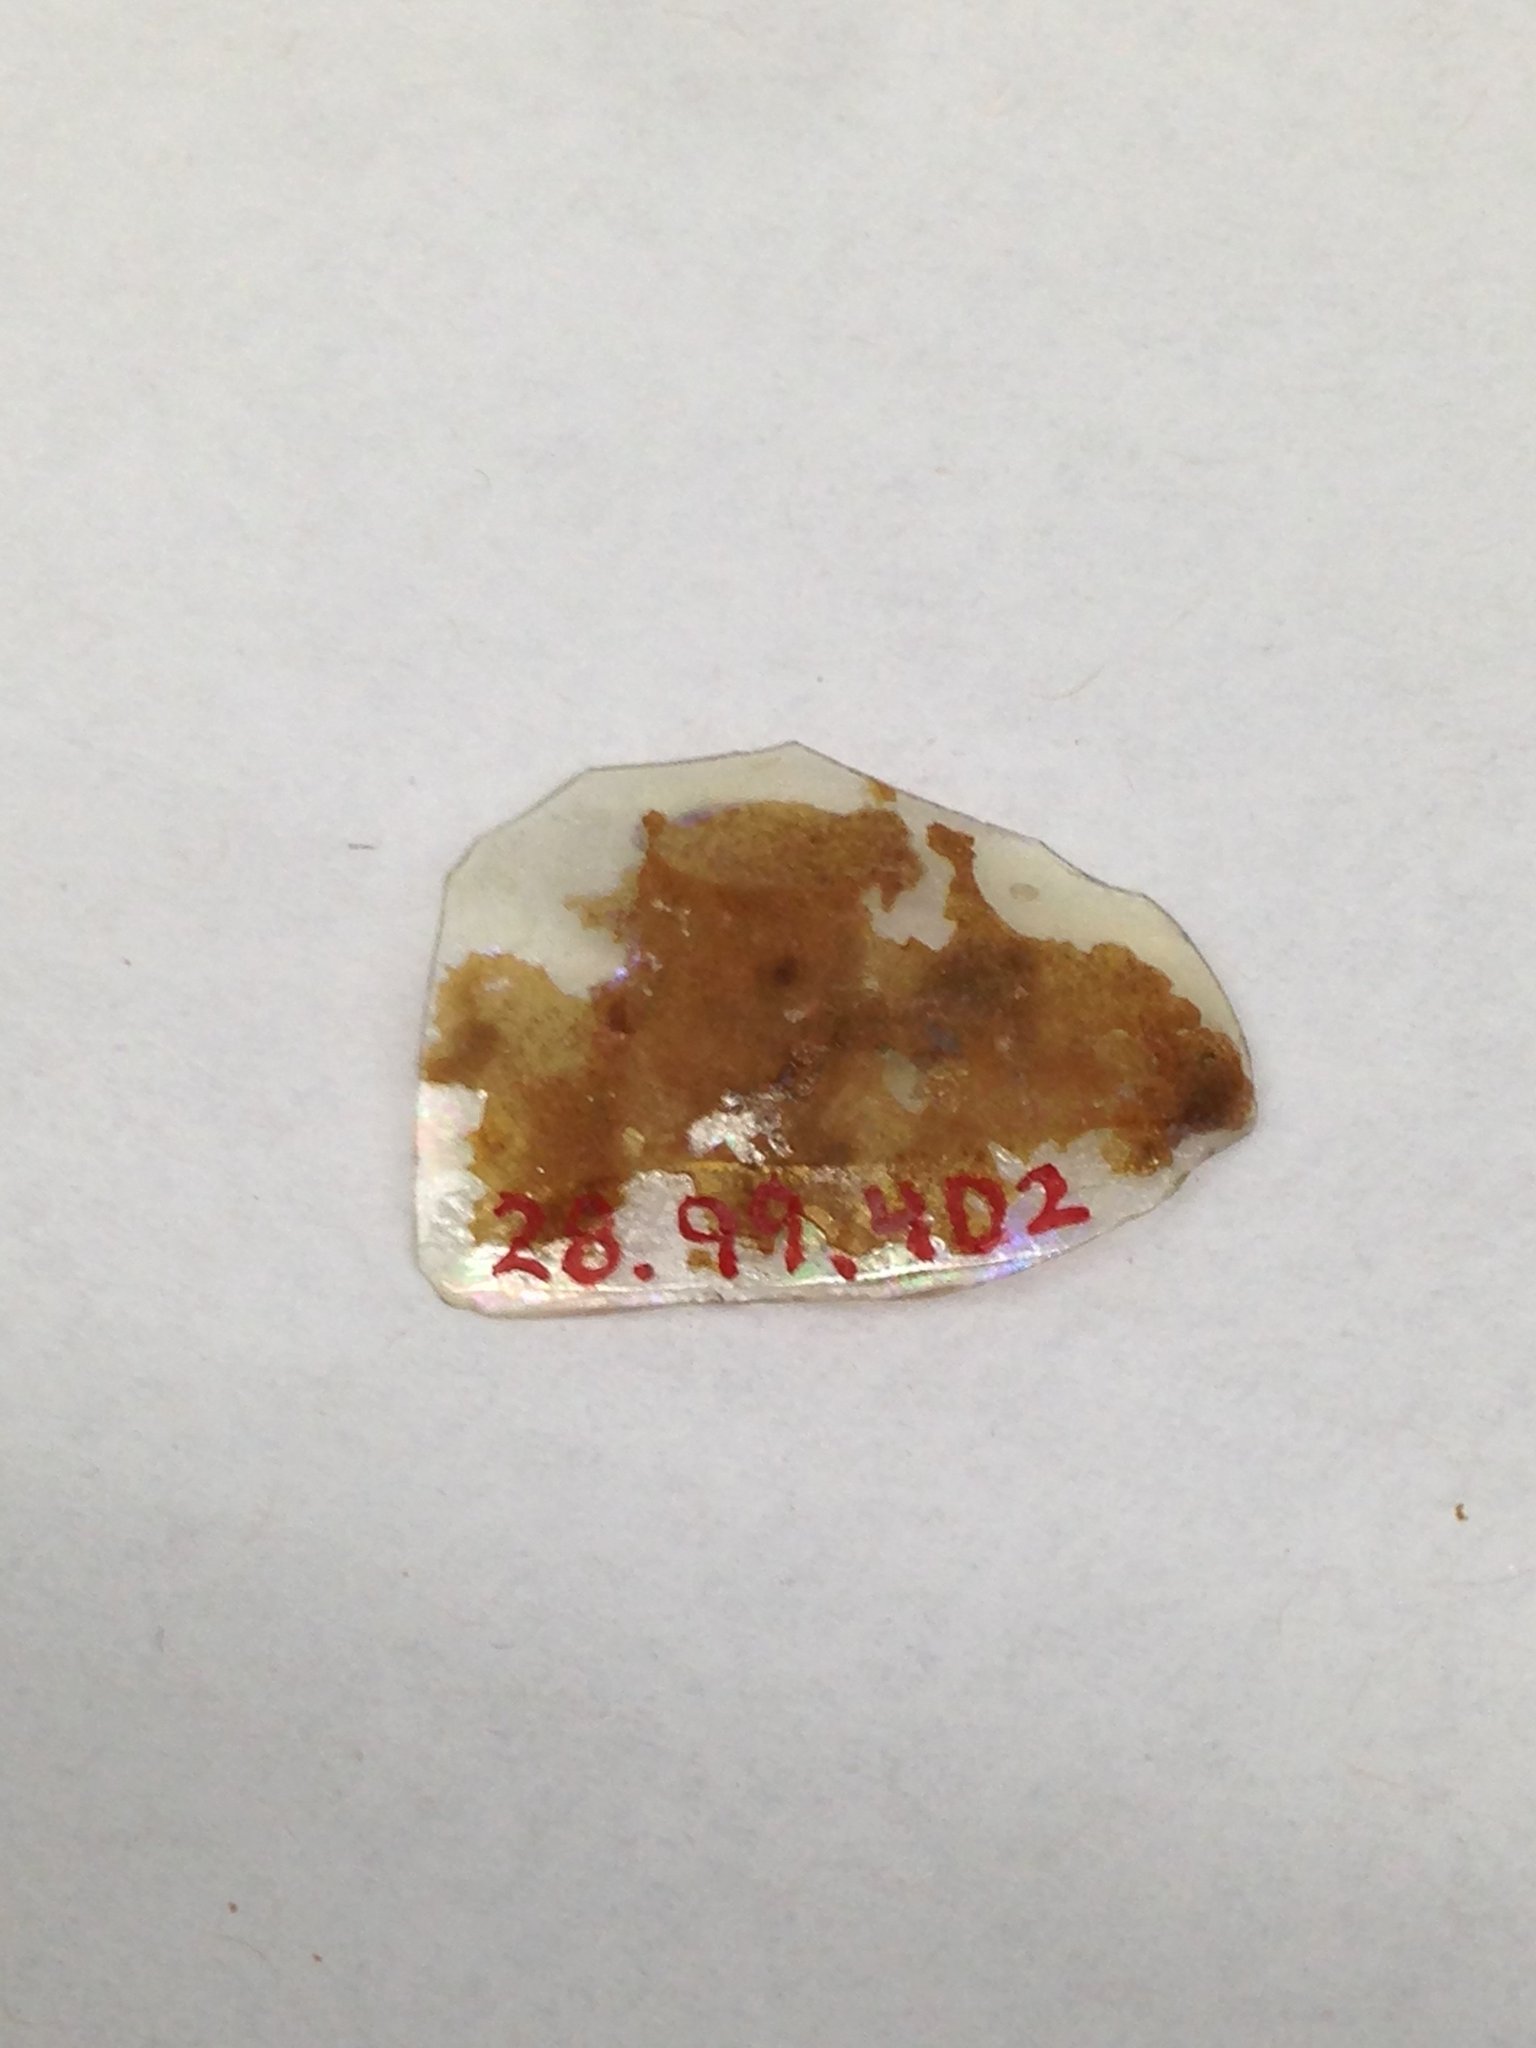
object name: fragment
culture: european or middle eastern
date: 1150-1250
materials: ceramic, glass